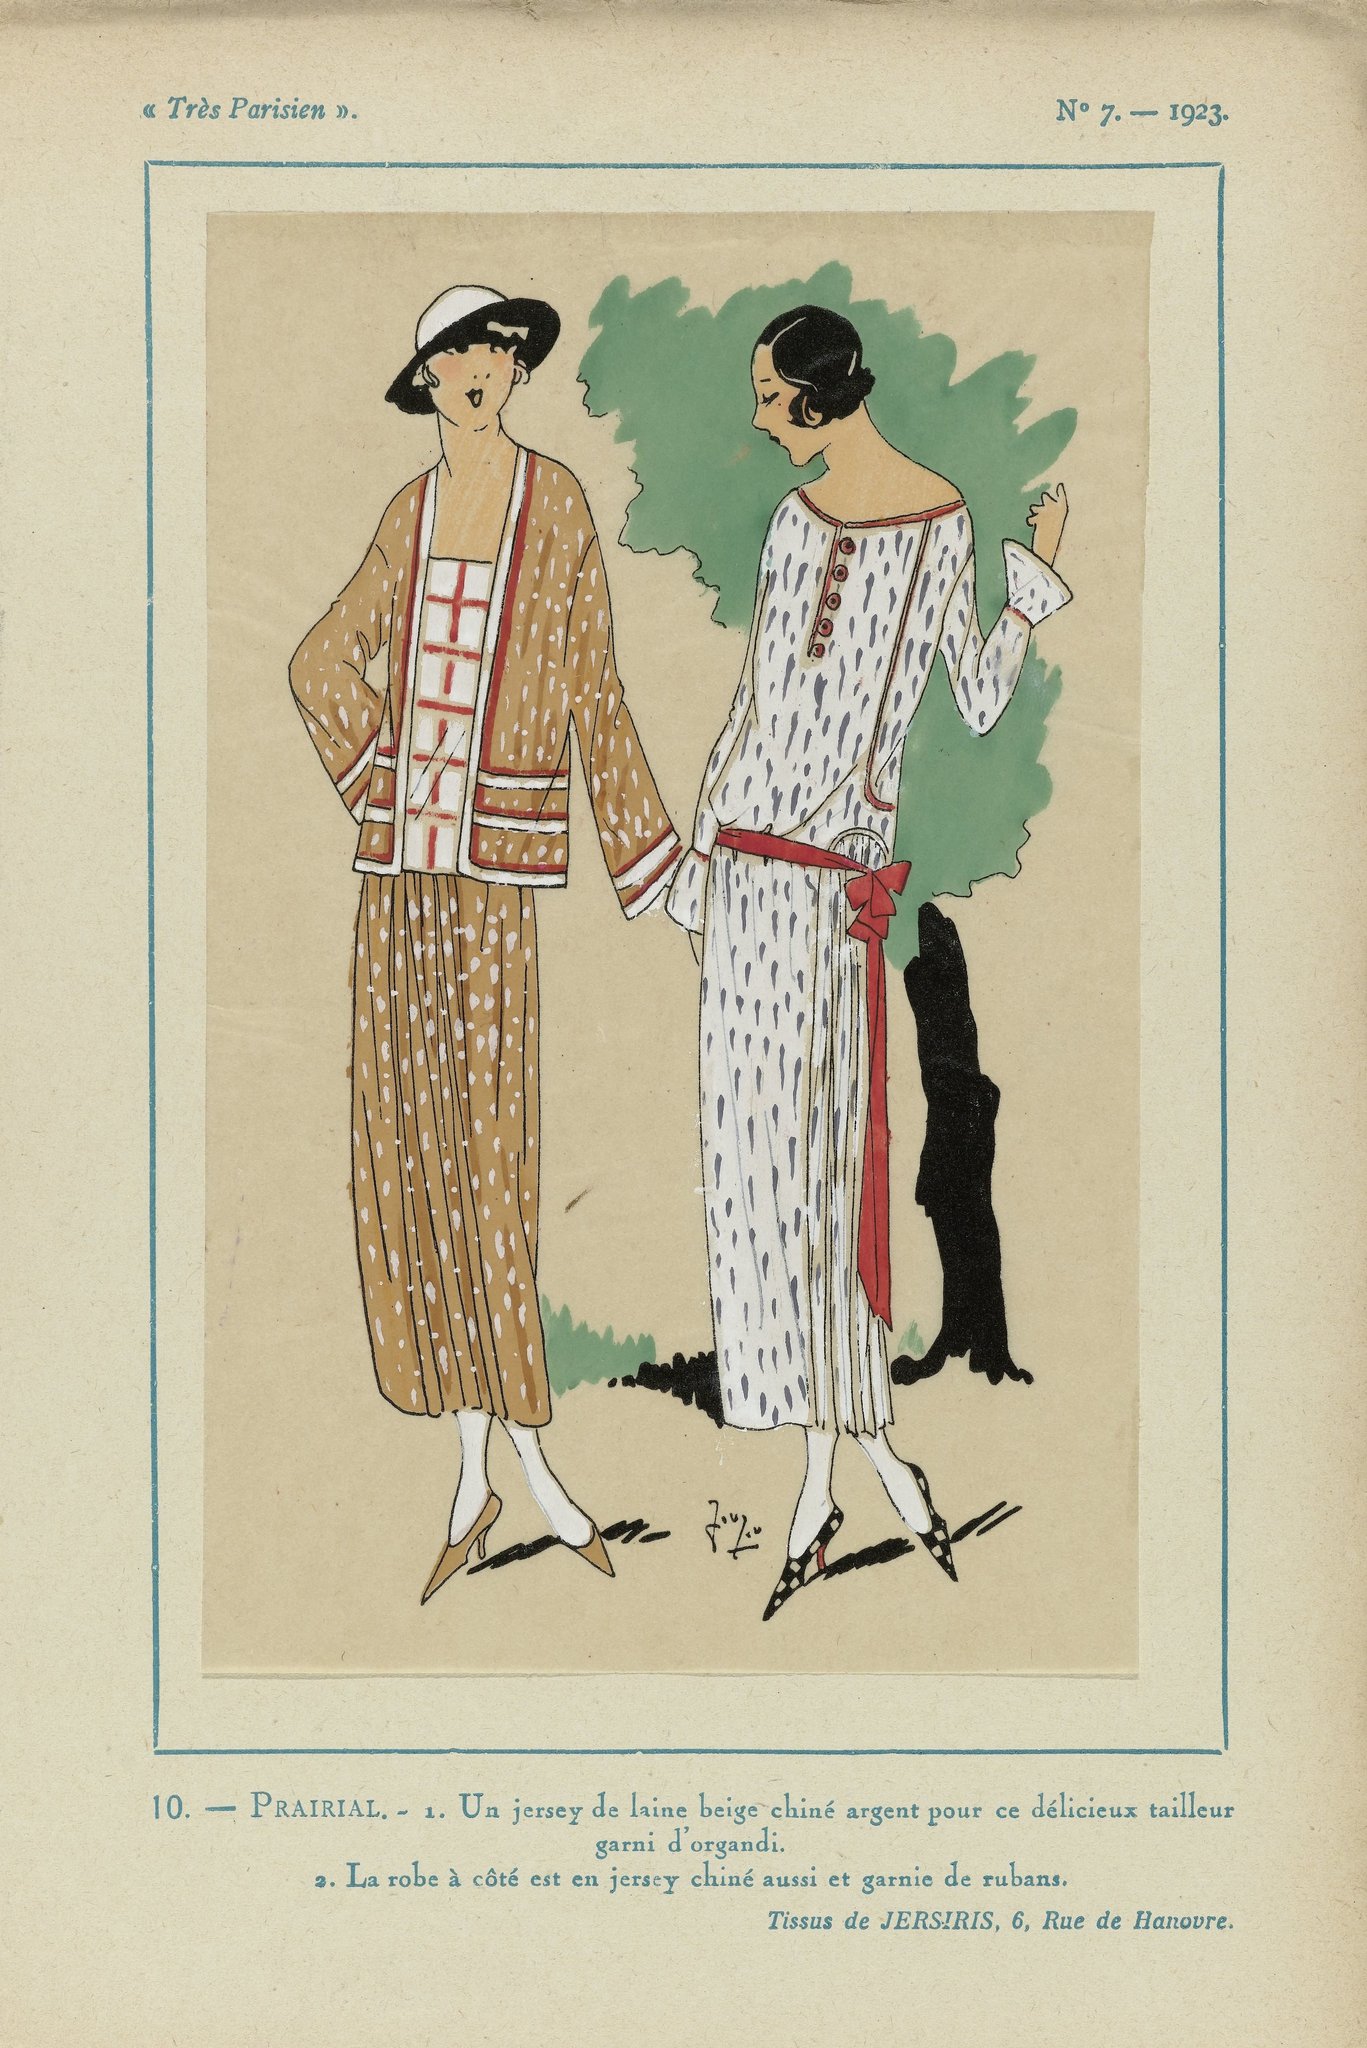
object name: fashion print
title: Très Parisien, 1923, No 7: 10.- PRAIRIAL. - 1. Un jersey de laine beige...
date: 1923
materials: paper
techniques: hand coloring, letterpress printing, lithography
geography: paris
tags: border, ribbon, braid (+ women's clothes), ensembles of pieces of clothing (suit) (+ women's clothes), fashion plates, head-gear: hat (+ women's clothes), dress, gown (+ women's clothes)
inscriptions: title: ‘Très Parisien / No 7. - 1923’, caption: ‘10. - PRAIRIAL. - 1. Un jersey de laine beige chiné argent pour ce délicieux tailleur garni d'organdi. 2. La robe à côté est en jersey chiné aussi et garnie de rubans. / Tissus de JERSIRIS, 6, Rue de Hanovre.’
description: 1. Een tailleur (mantelpak) van beige wollen jersey 'chiné argent'(zilverkleurige vlekken?), gegarneerd met organdi. 2. Jurk van 'jersey chiné' gegarneerd met linten. Stoffen van Jersiris. Prent uit het modetijdschrift Très Parisien (1920-1936).